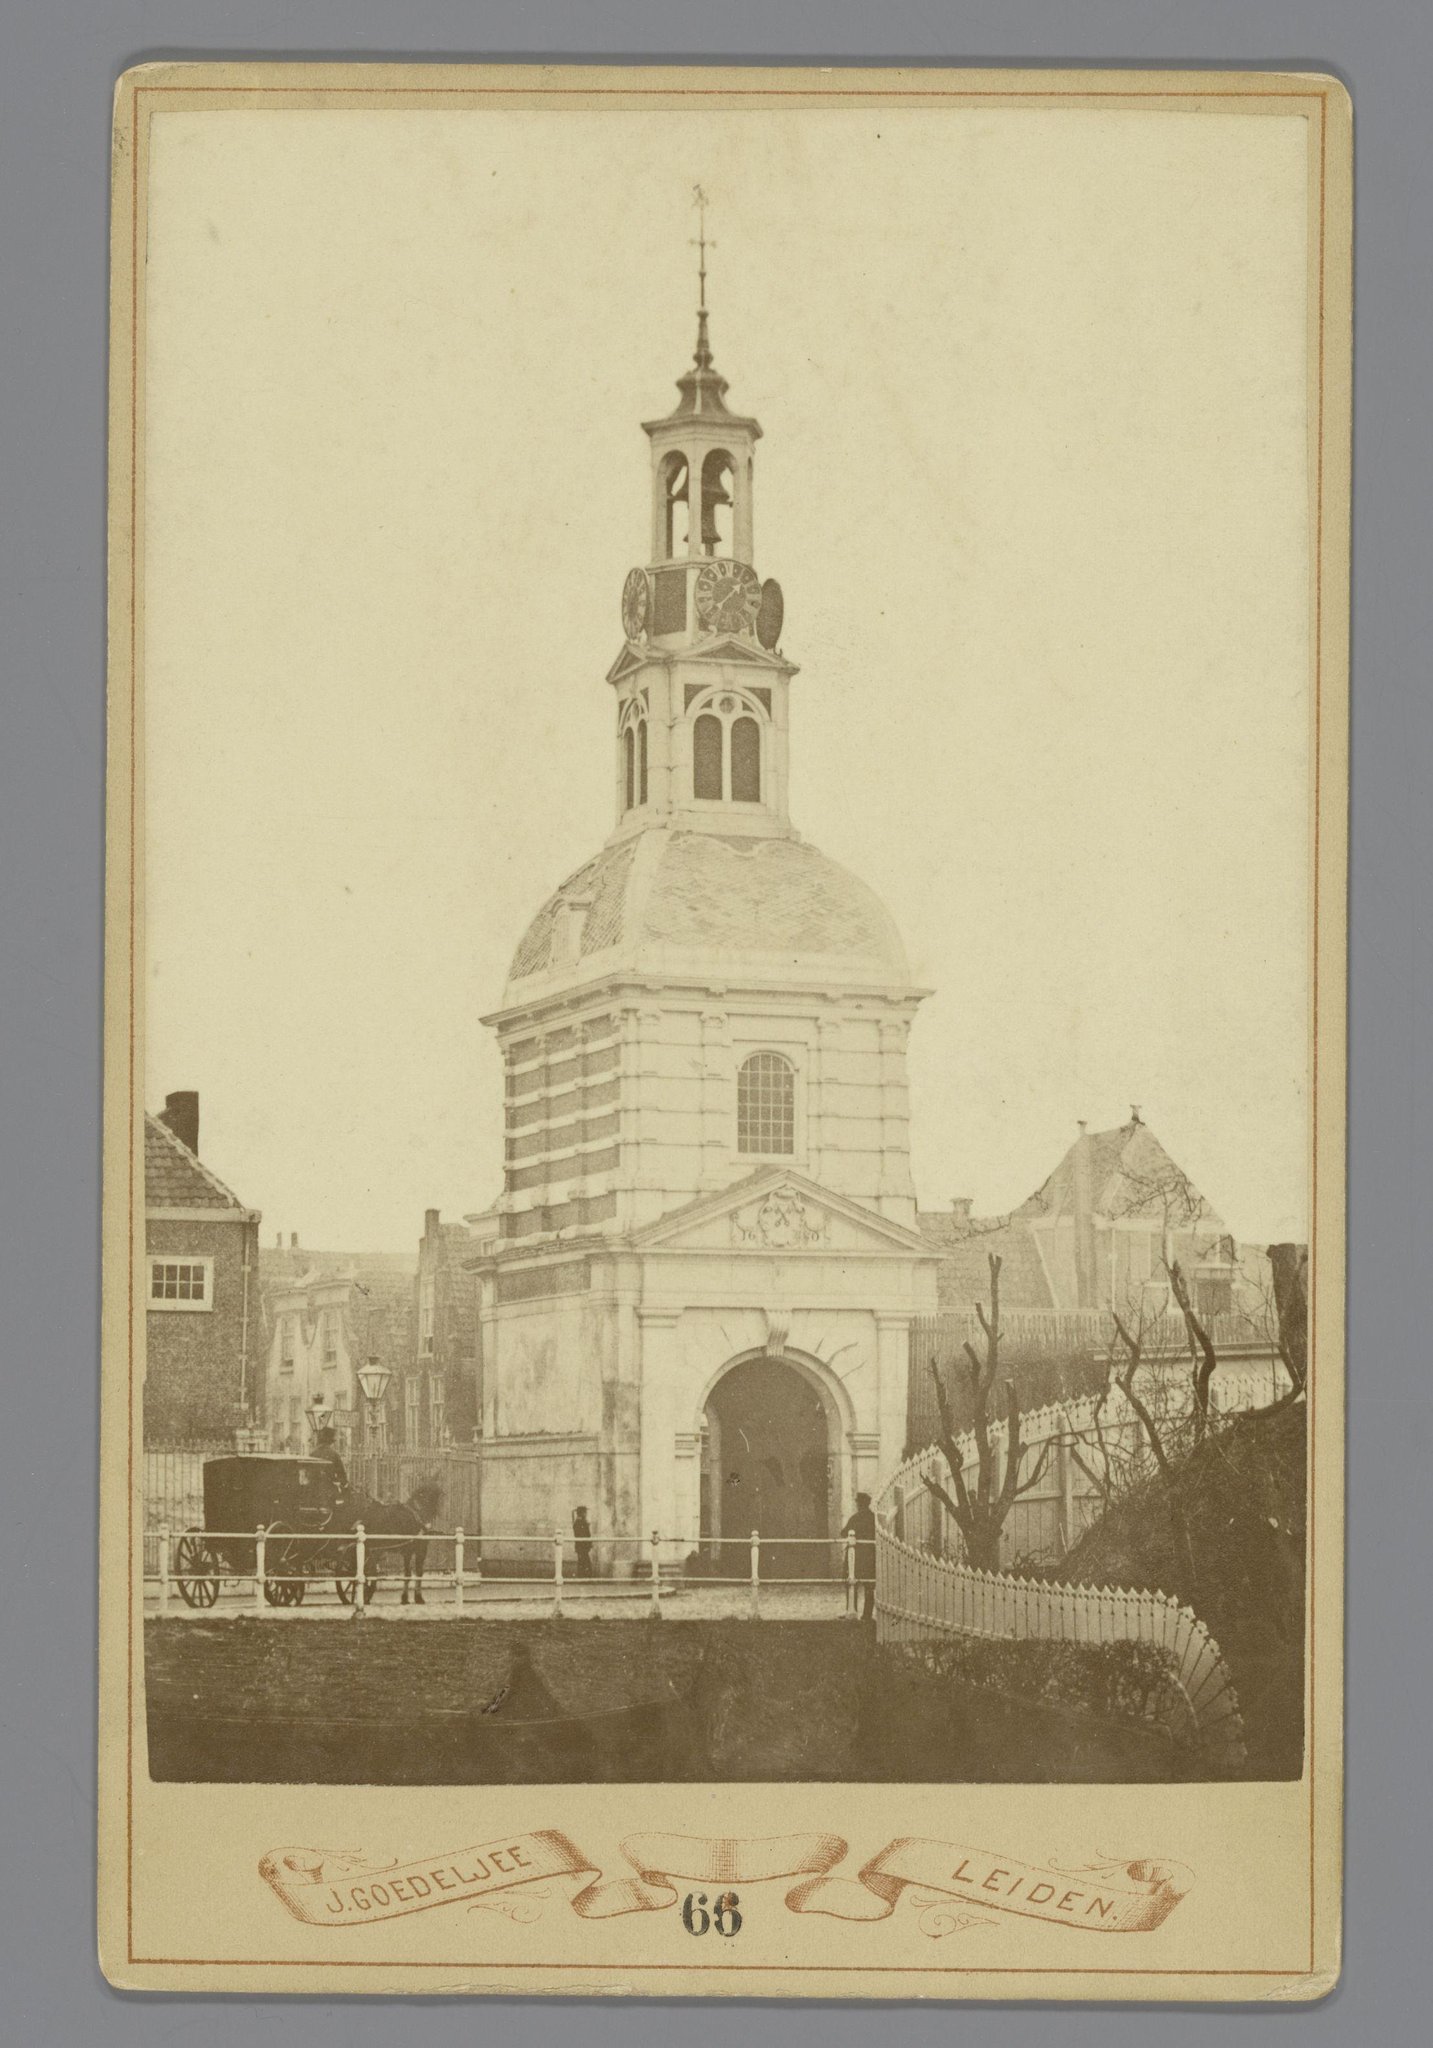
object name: cabinet photograph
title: Gezicht op de Witte Poort te Leiden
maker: jan goedeljee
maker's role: fotograaf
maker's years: 1824-1905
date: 1860-1864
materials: cardboard, photographic support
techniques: albumen print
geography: leiden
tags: city-gate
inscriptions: inscription: ‘J. Goedeljee (...) Leiden/ Hoogewoerd 160/ naby de Plantage’, annotation: ‘Leiden/ koepoort, afgebroken’, inscription: ‘J. Goedeljee/ Leiden/ 66’